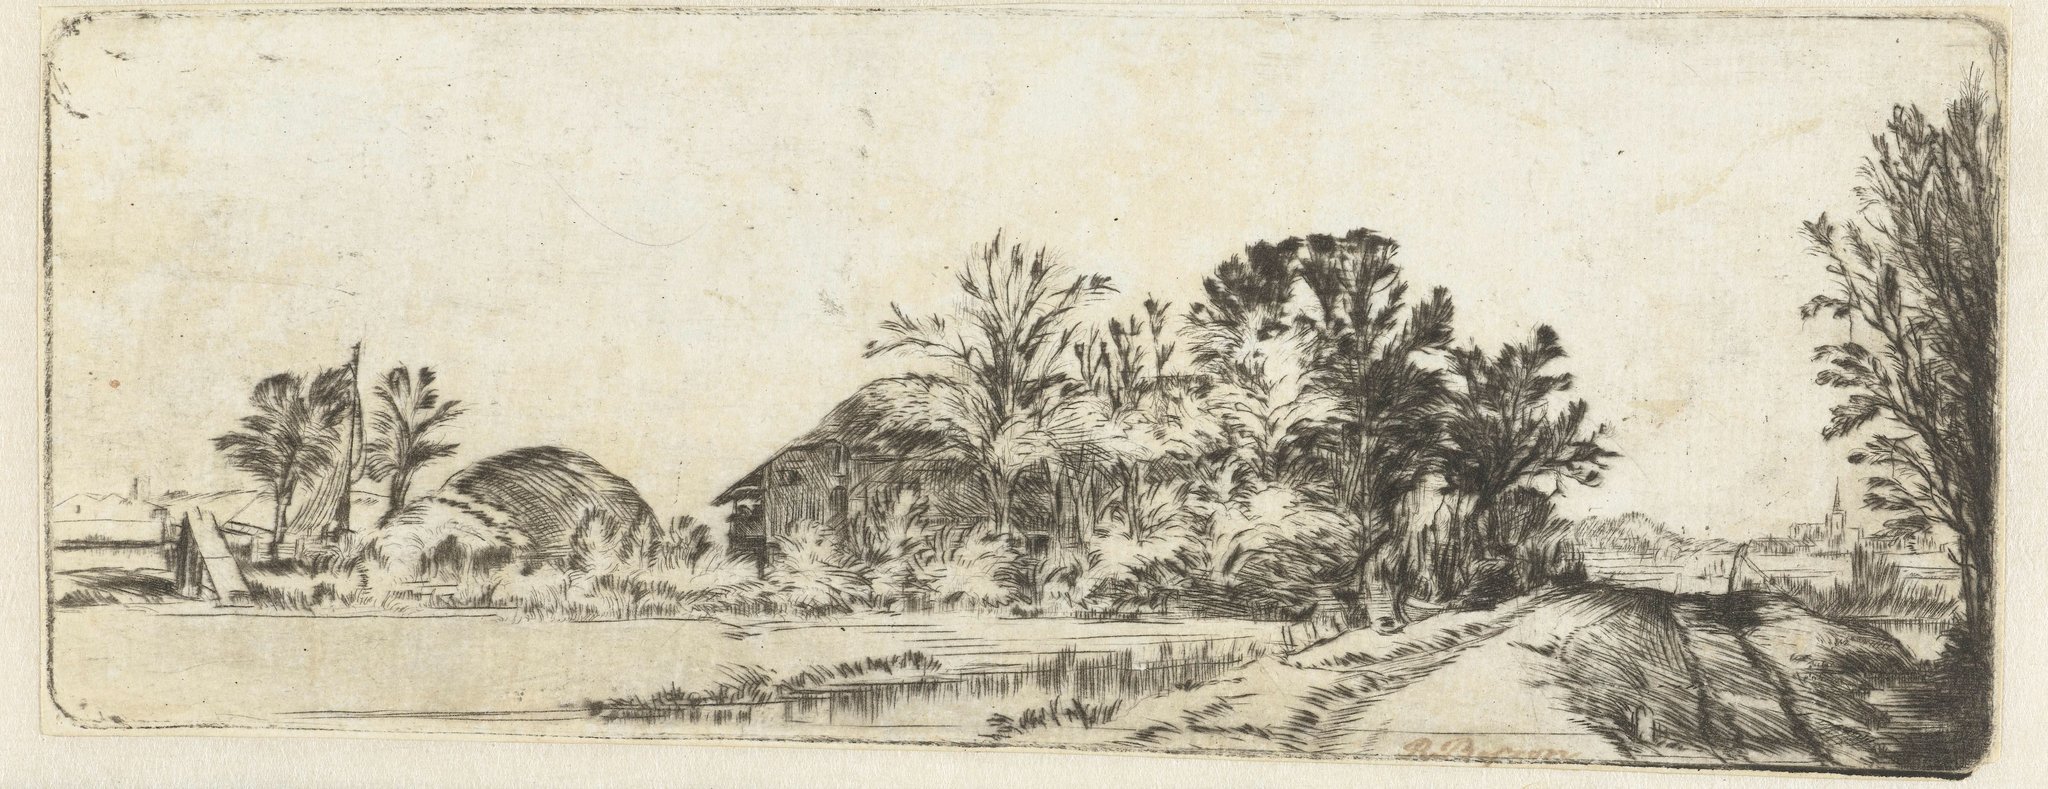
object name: print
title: Landscape with a farmhouse along a road beside a canal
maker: richard byron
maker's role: print maker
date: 1750-1799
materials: paper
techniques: drypoint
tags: monumental adornments (in city)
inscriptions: collector's mark: Lugt 2228, signature: ‘R. Byron’, collector's mark: Lugt 2760